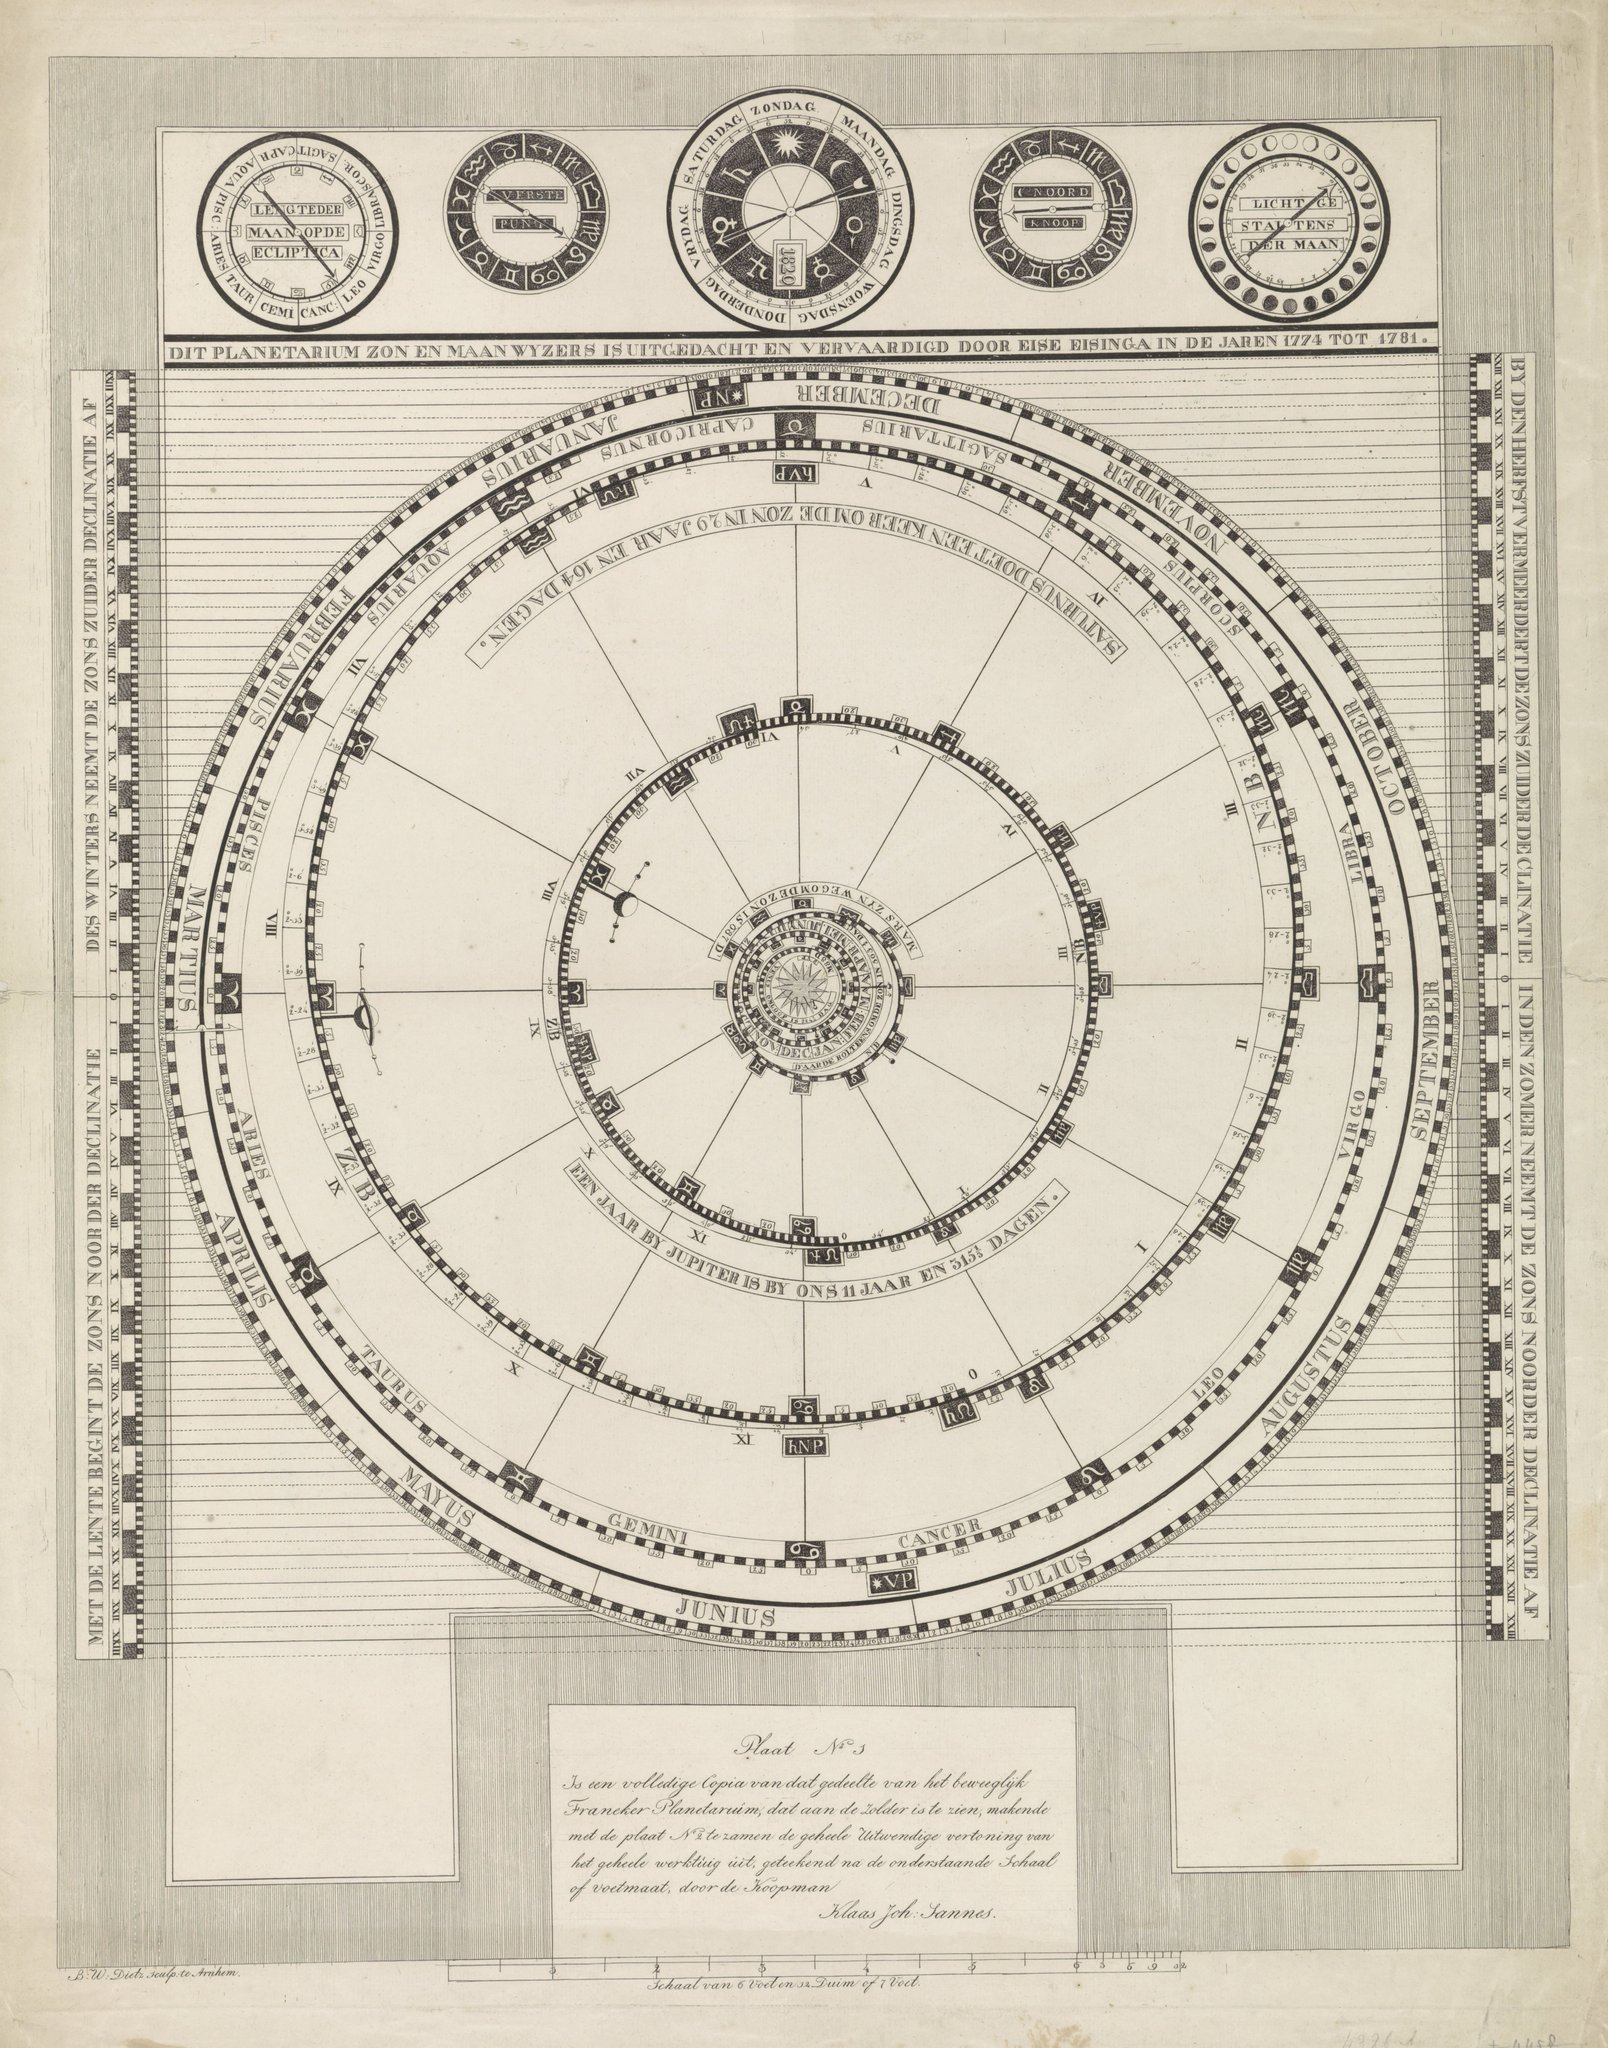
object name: print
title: Plan van bewegelijk planetarium van Eise Eisinga te Franeker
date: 1824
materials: paper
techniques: etching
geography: arnhem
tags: orrery, planetarium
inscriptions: collector's mark: Lugt 2228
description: Prent uit: Klaas Joh. Sannes, Kunststuk verbeeldende een volledig bewegelijk Hemels-Gestel uitgedacht en vervaardigd door Eise Eisinga, 1824, plaat 1